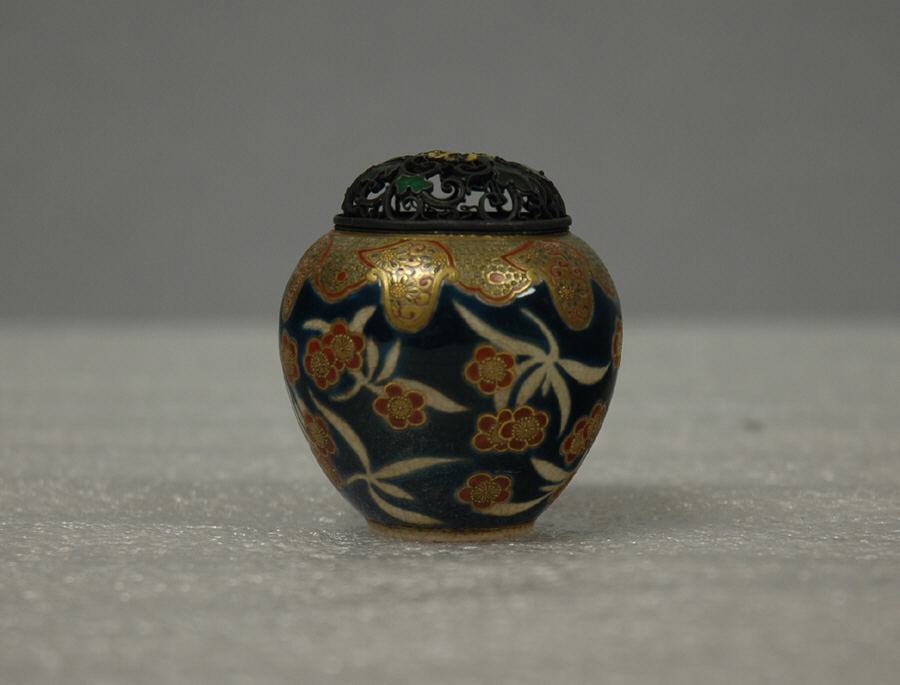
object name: covered jar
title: Small Covered Jar with Design of Cherry Blossoms and Lambrequin Border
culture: japanese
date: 1801-1900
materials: enamel, gold, porcelain, silver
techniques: overglaze, polychrome